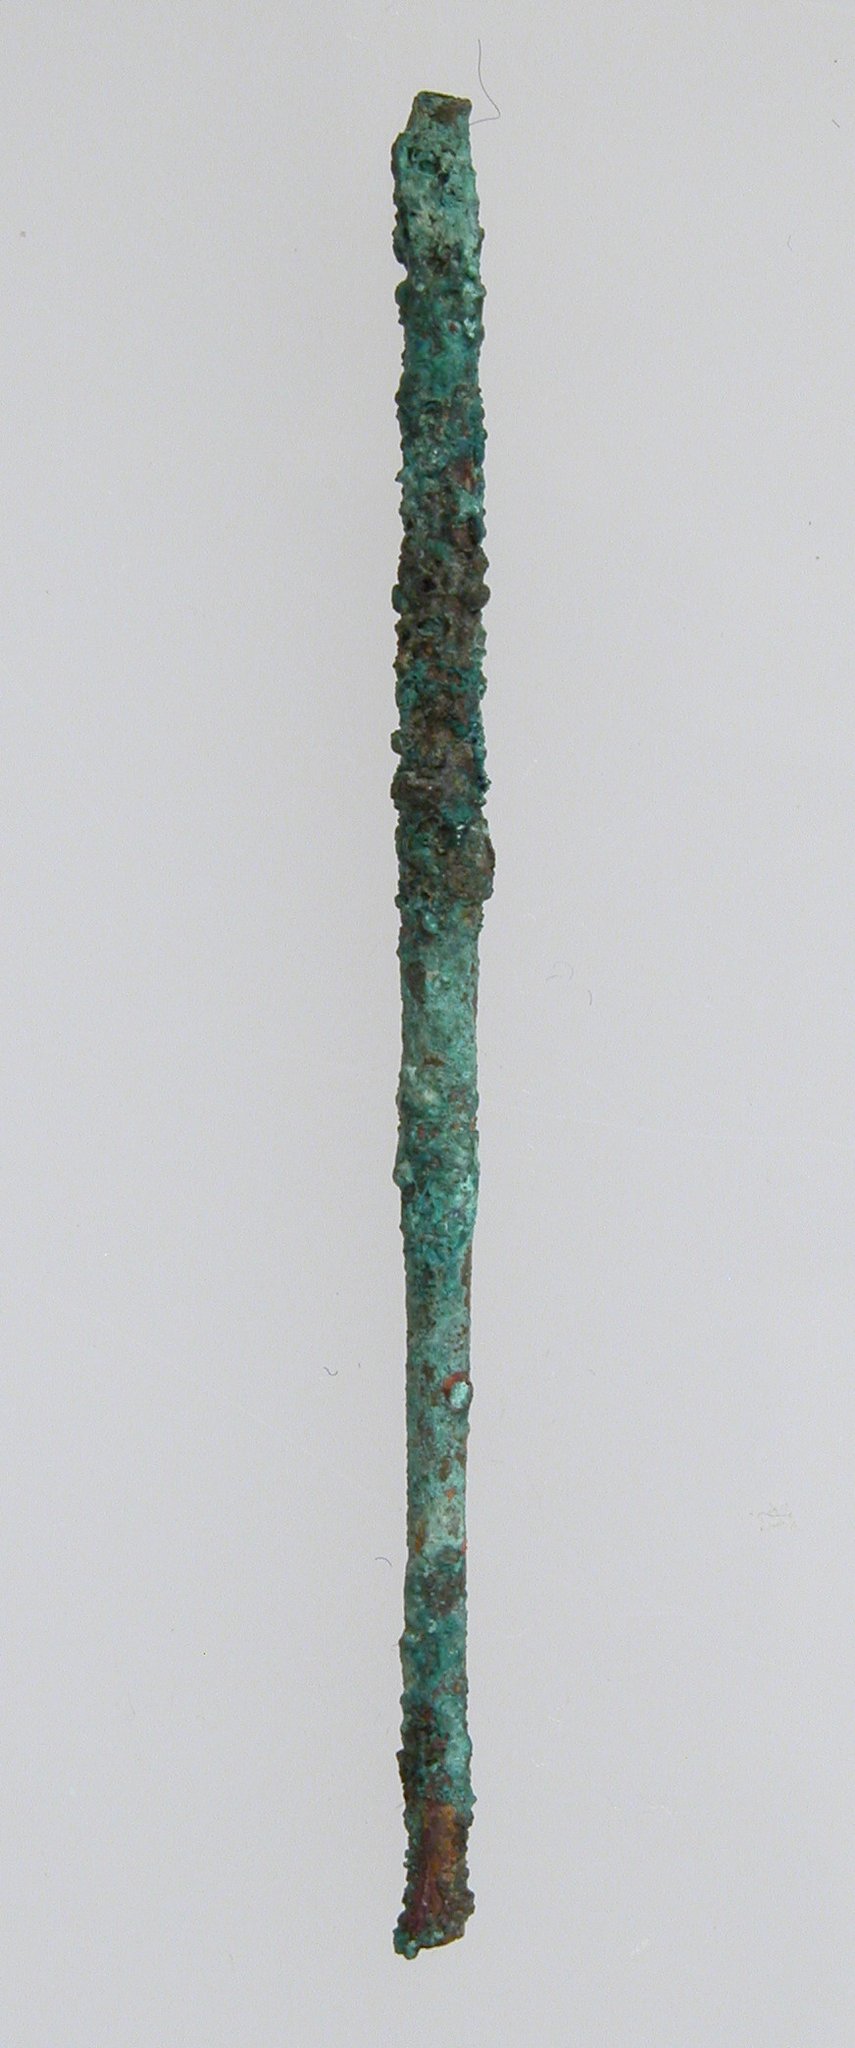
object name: pin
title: Pin Part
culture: roman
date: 200-500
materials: copper alloy